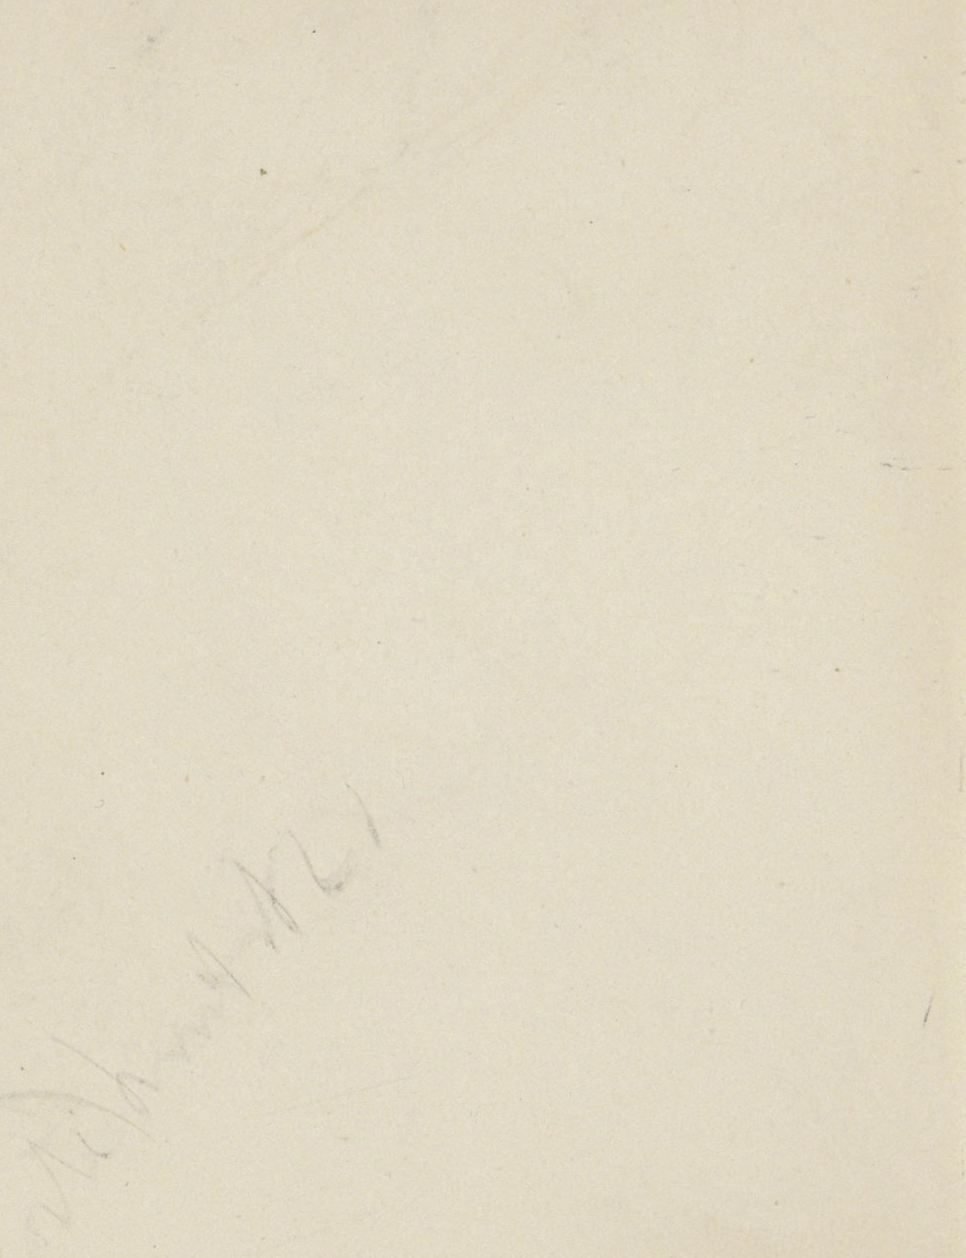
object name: sketchbook leaf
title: Notitie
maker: reijer stolk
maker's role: draughtsman, print maker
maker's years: 1896-1945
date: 1906-1945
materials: paper, pencil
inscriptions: annotation: ‘R[...]tolk’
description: Blad 30 verso uit een schetsboek met 69 bladen.